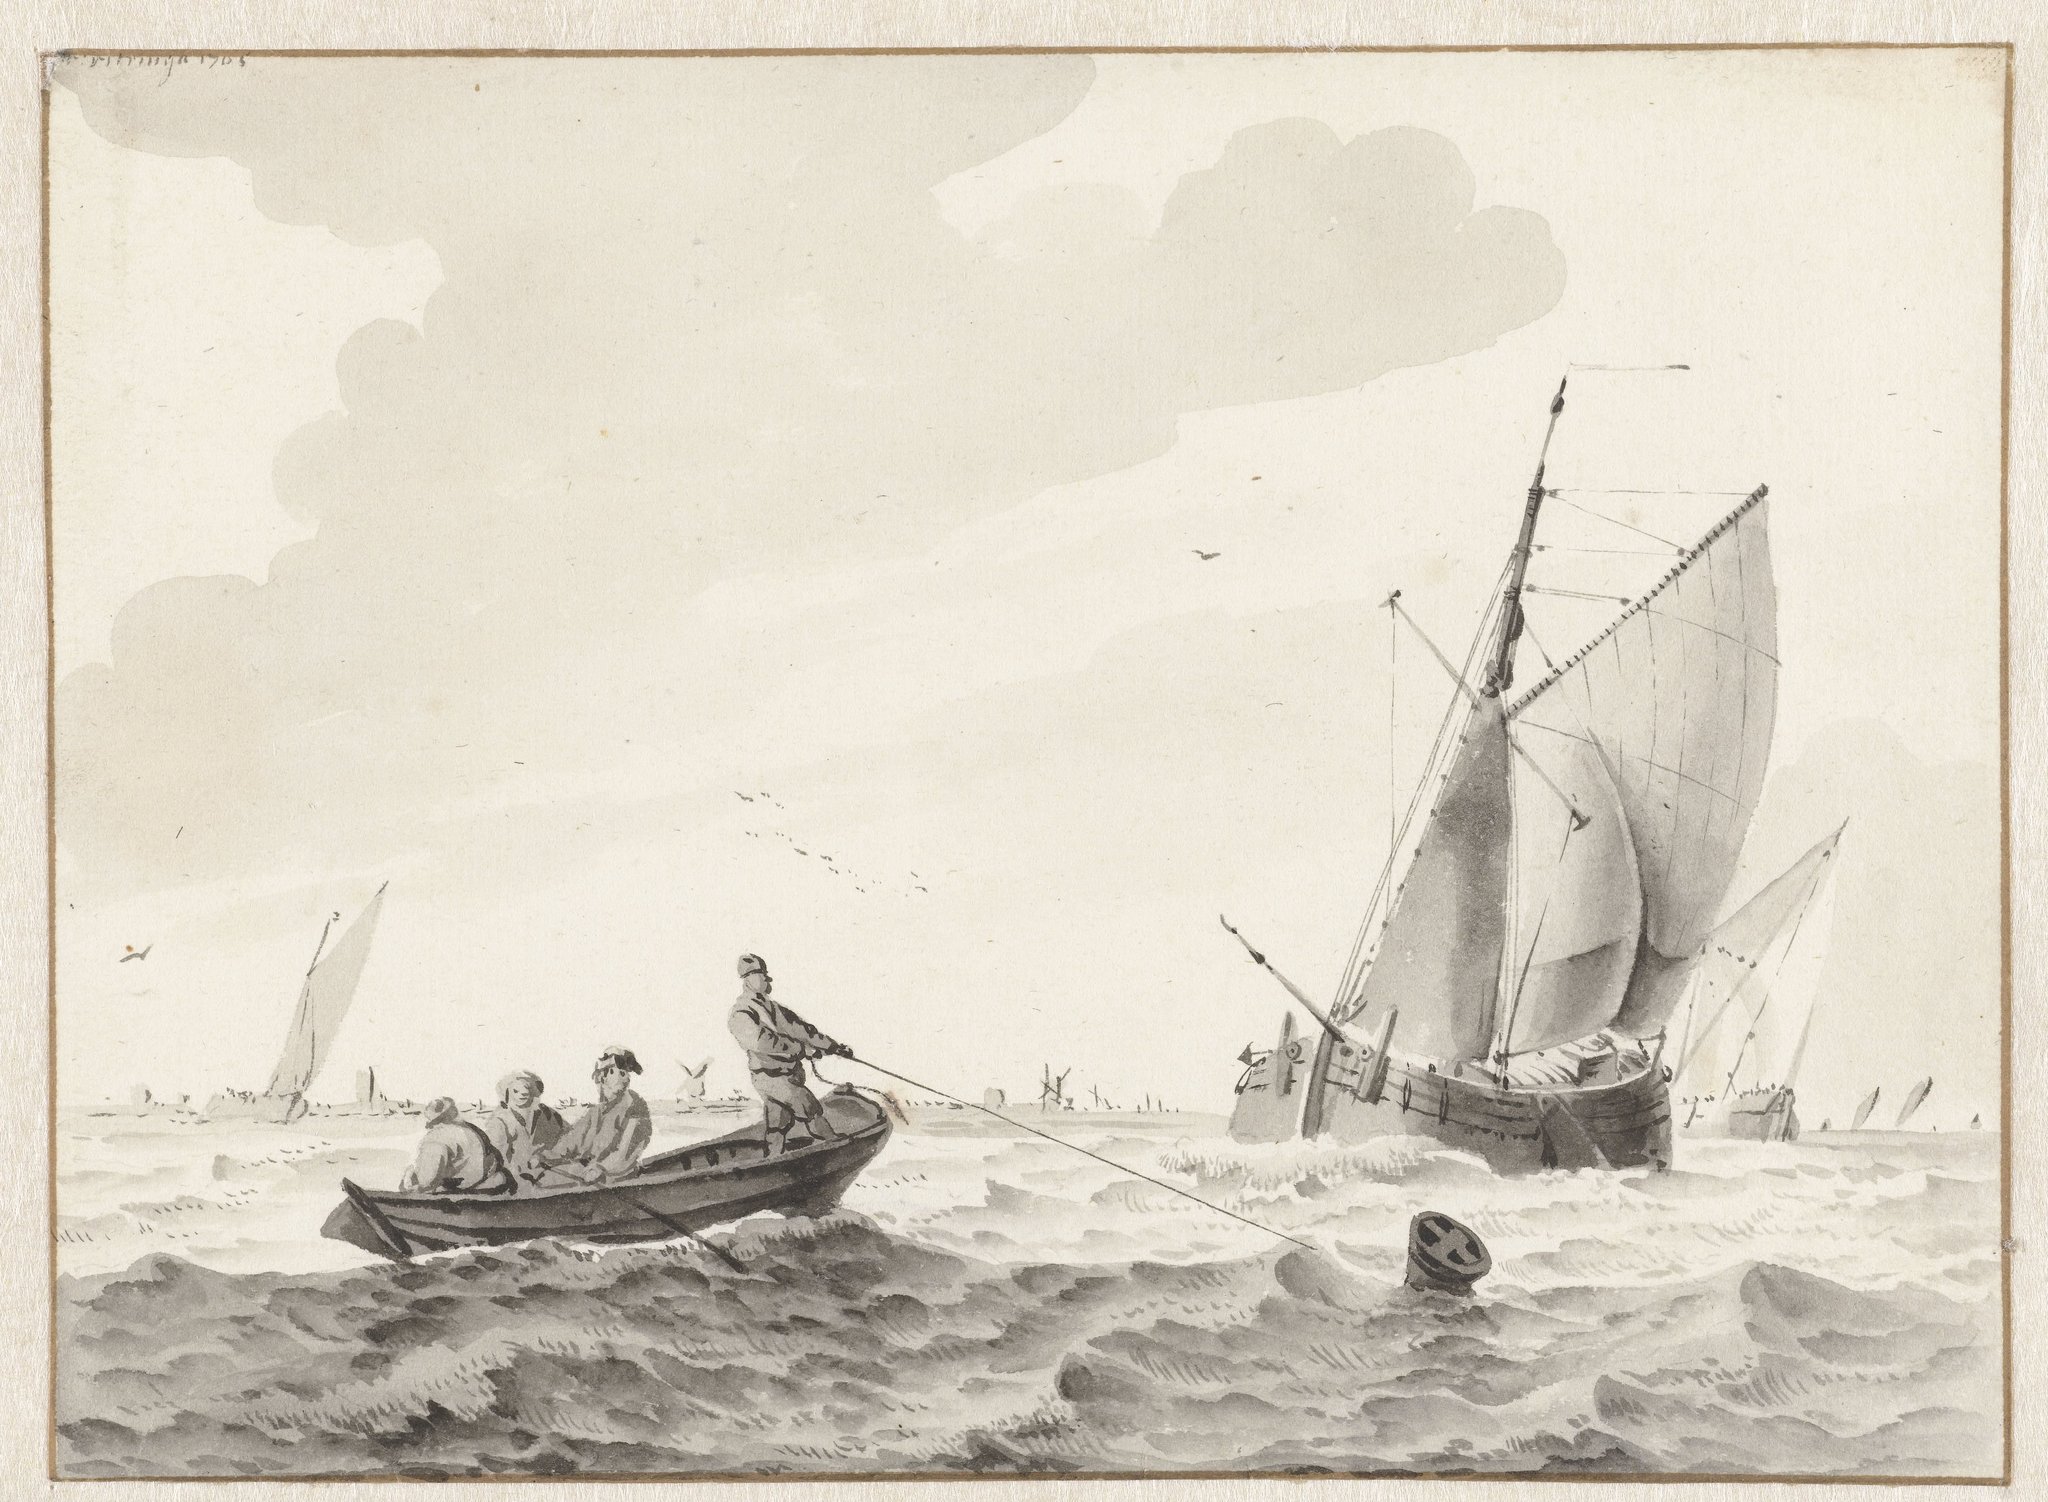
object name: drawing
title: Golvend water met een roeiboot bij een boei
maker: wigerus vitringa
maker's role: draughtsman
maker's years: 1657-1721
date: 1705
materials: ink, paper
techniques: brush, pen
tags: rowing-boat, canoe, etc., sea (seascape)